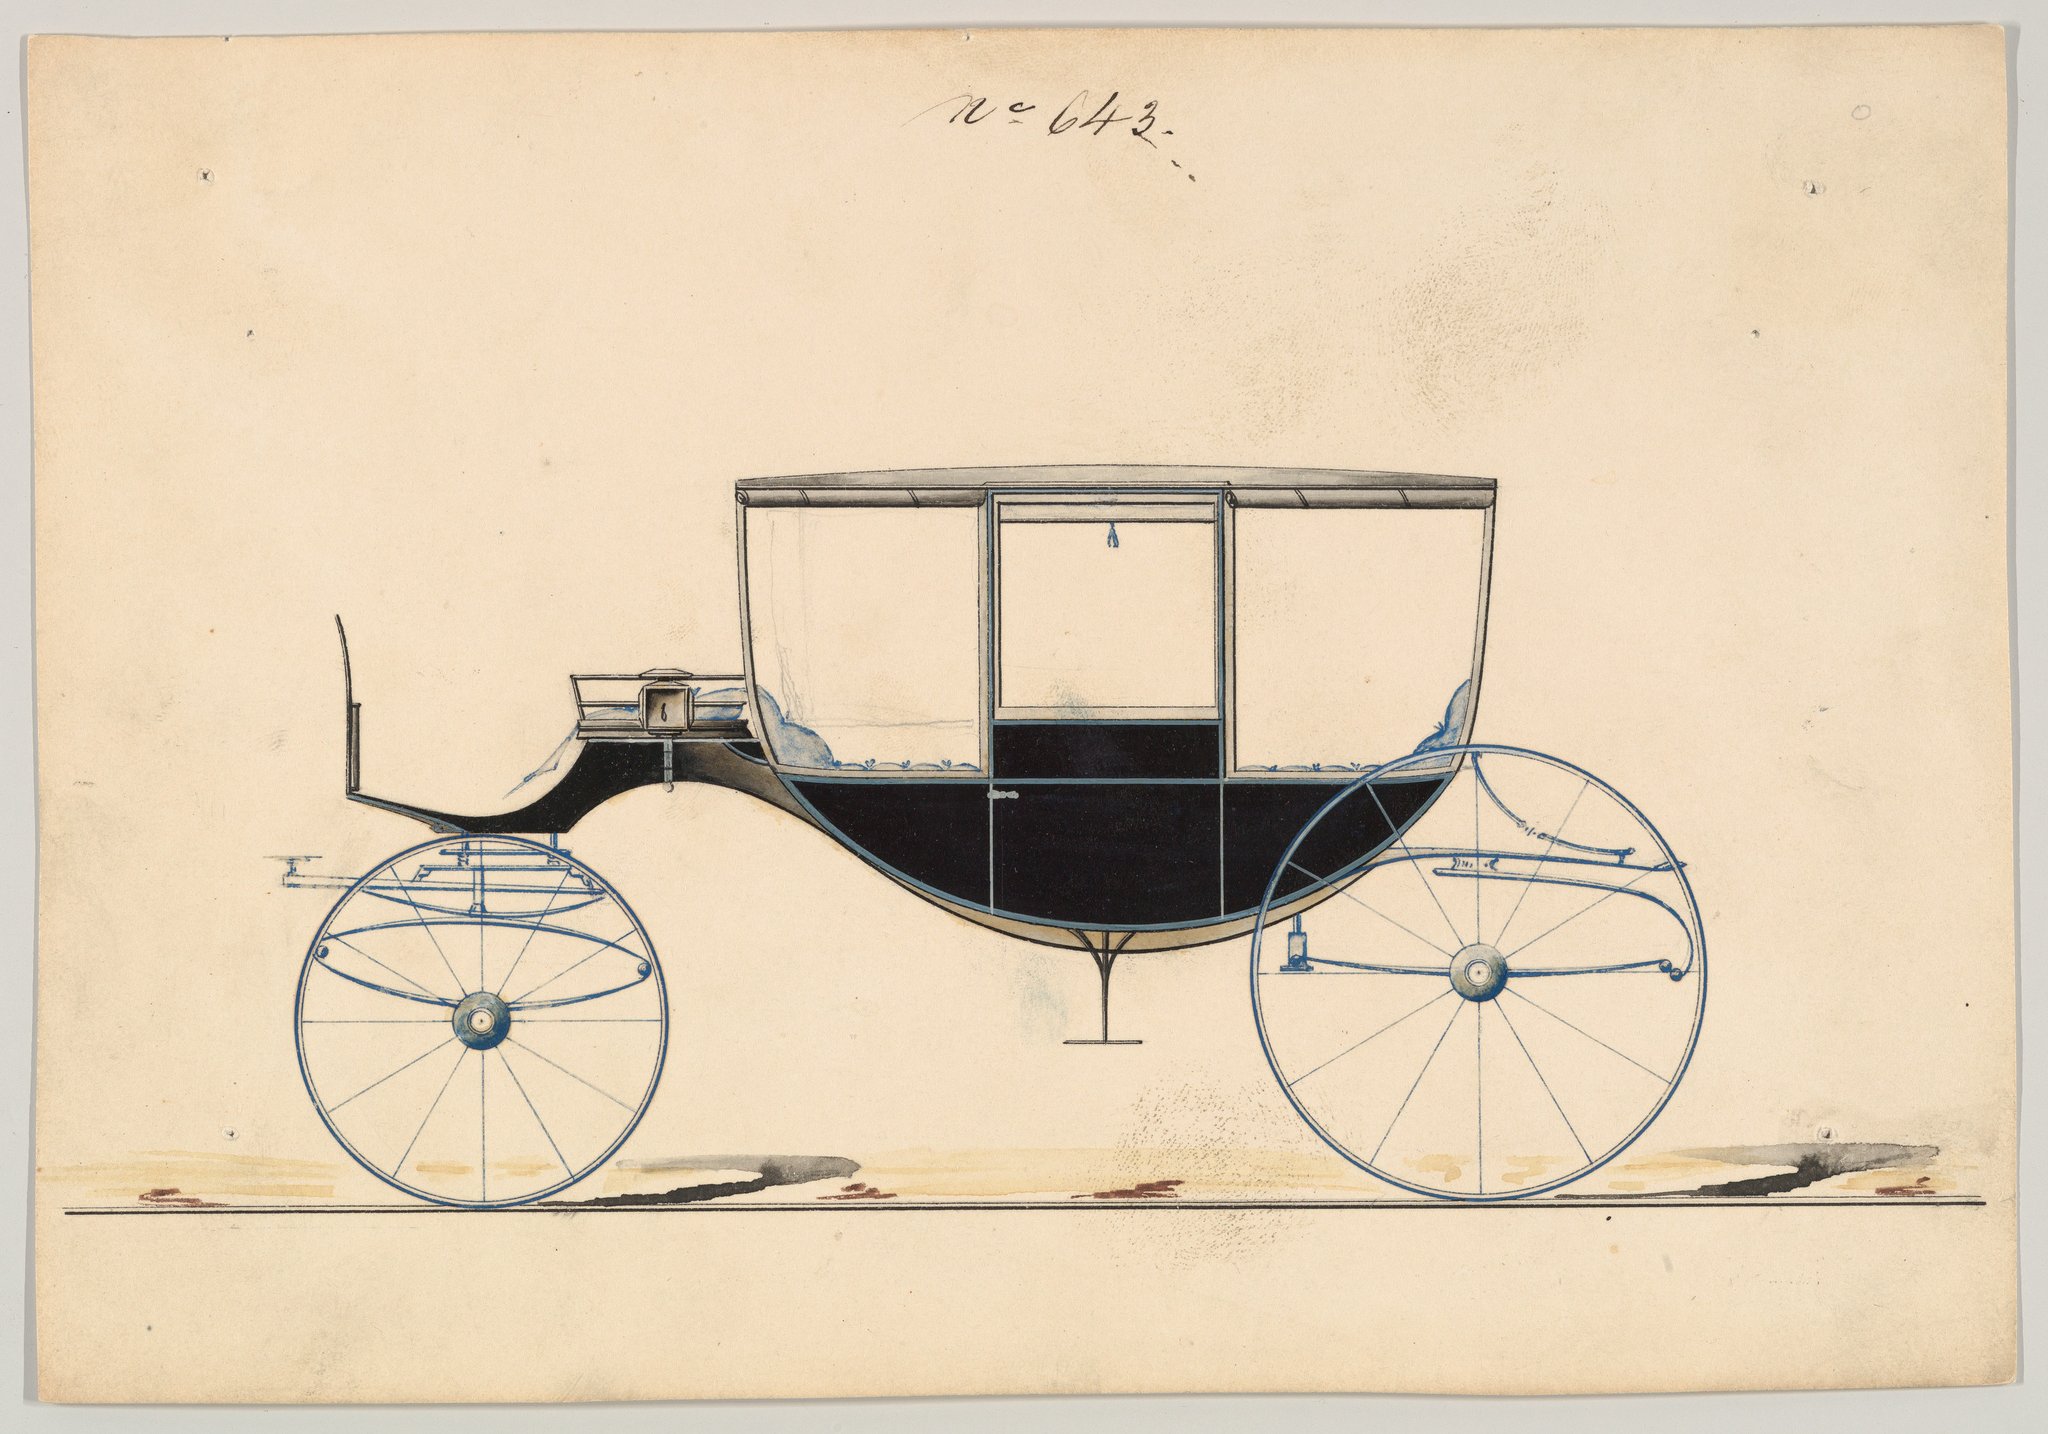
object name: drawing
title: Curtain Coach #643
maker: brewster & co.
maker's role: manufacturer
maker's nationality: american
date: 1870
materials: graphite, gum arabic, ink, watercolor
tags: carriages